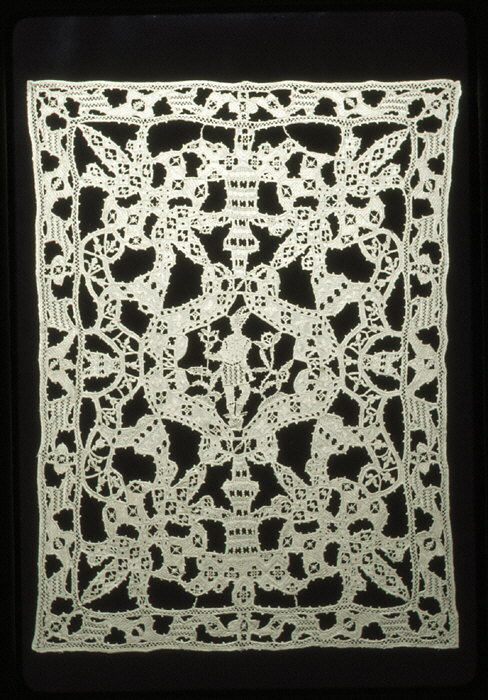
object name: panel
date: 1501-1600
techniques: embroidery